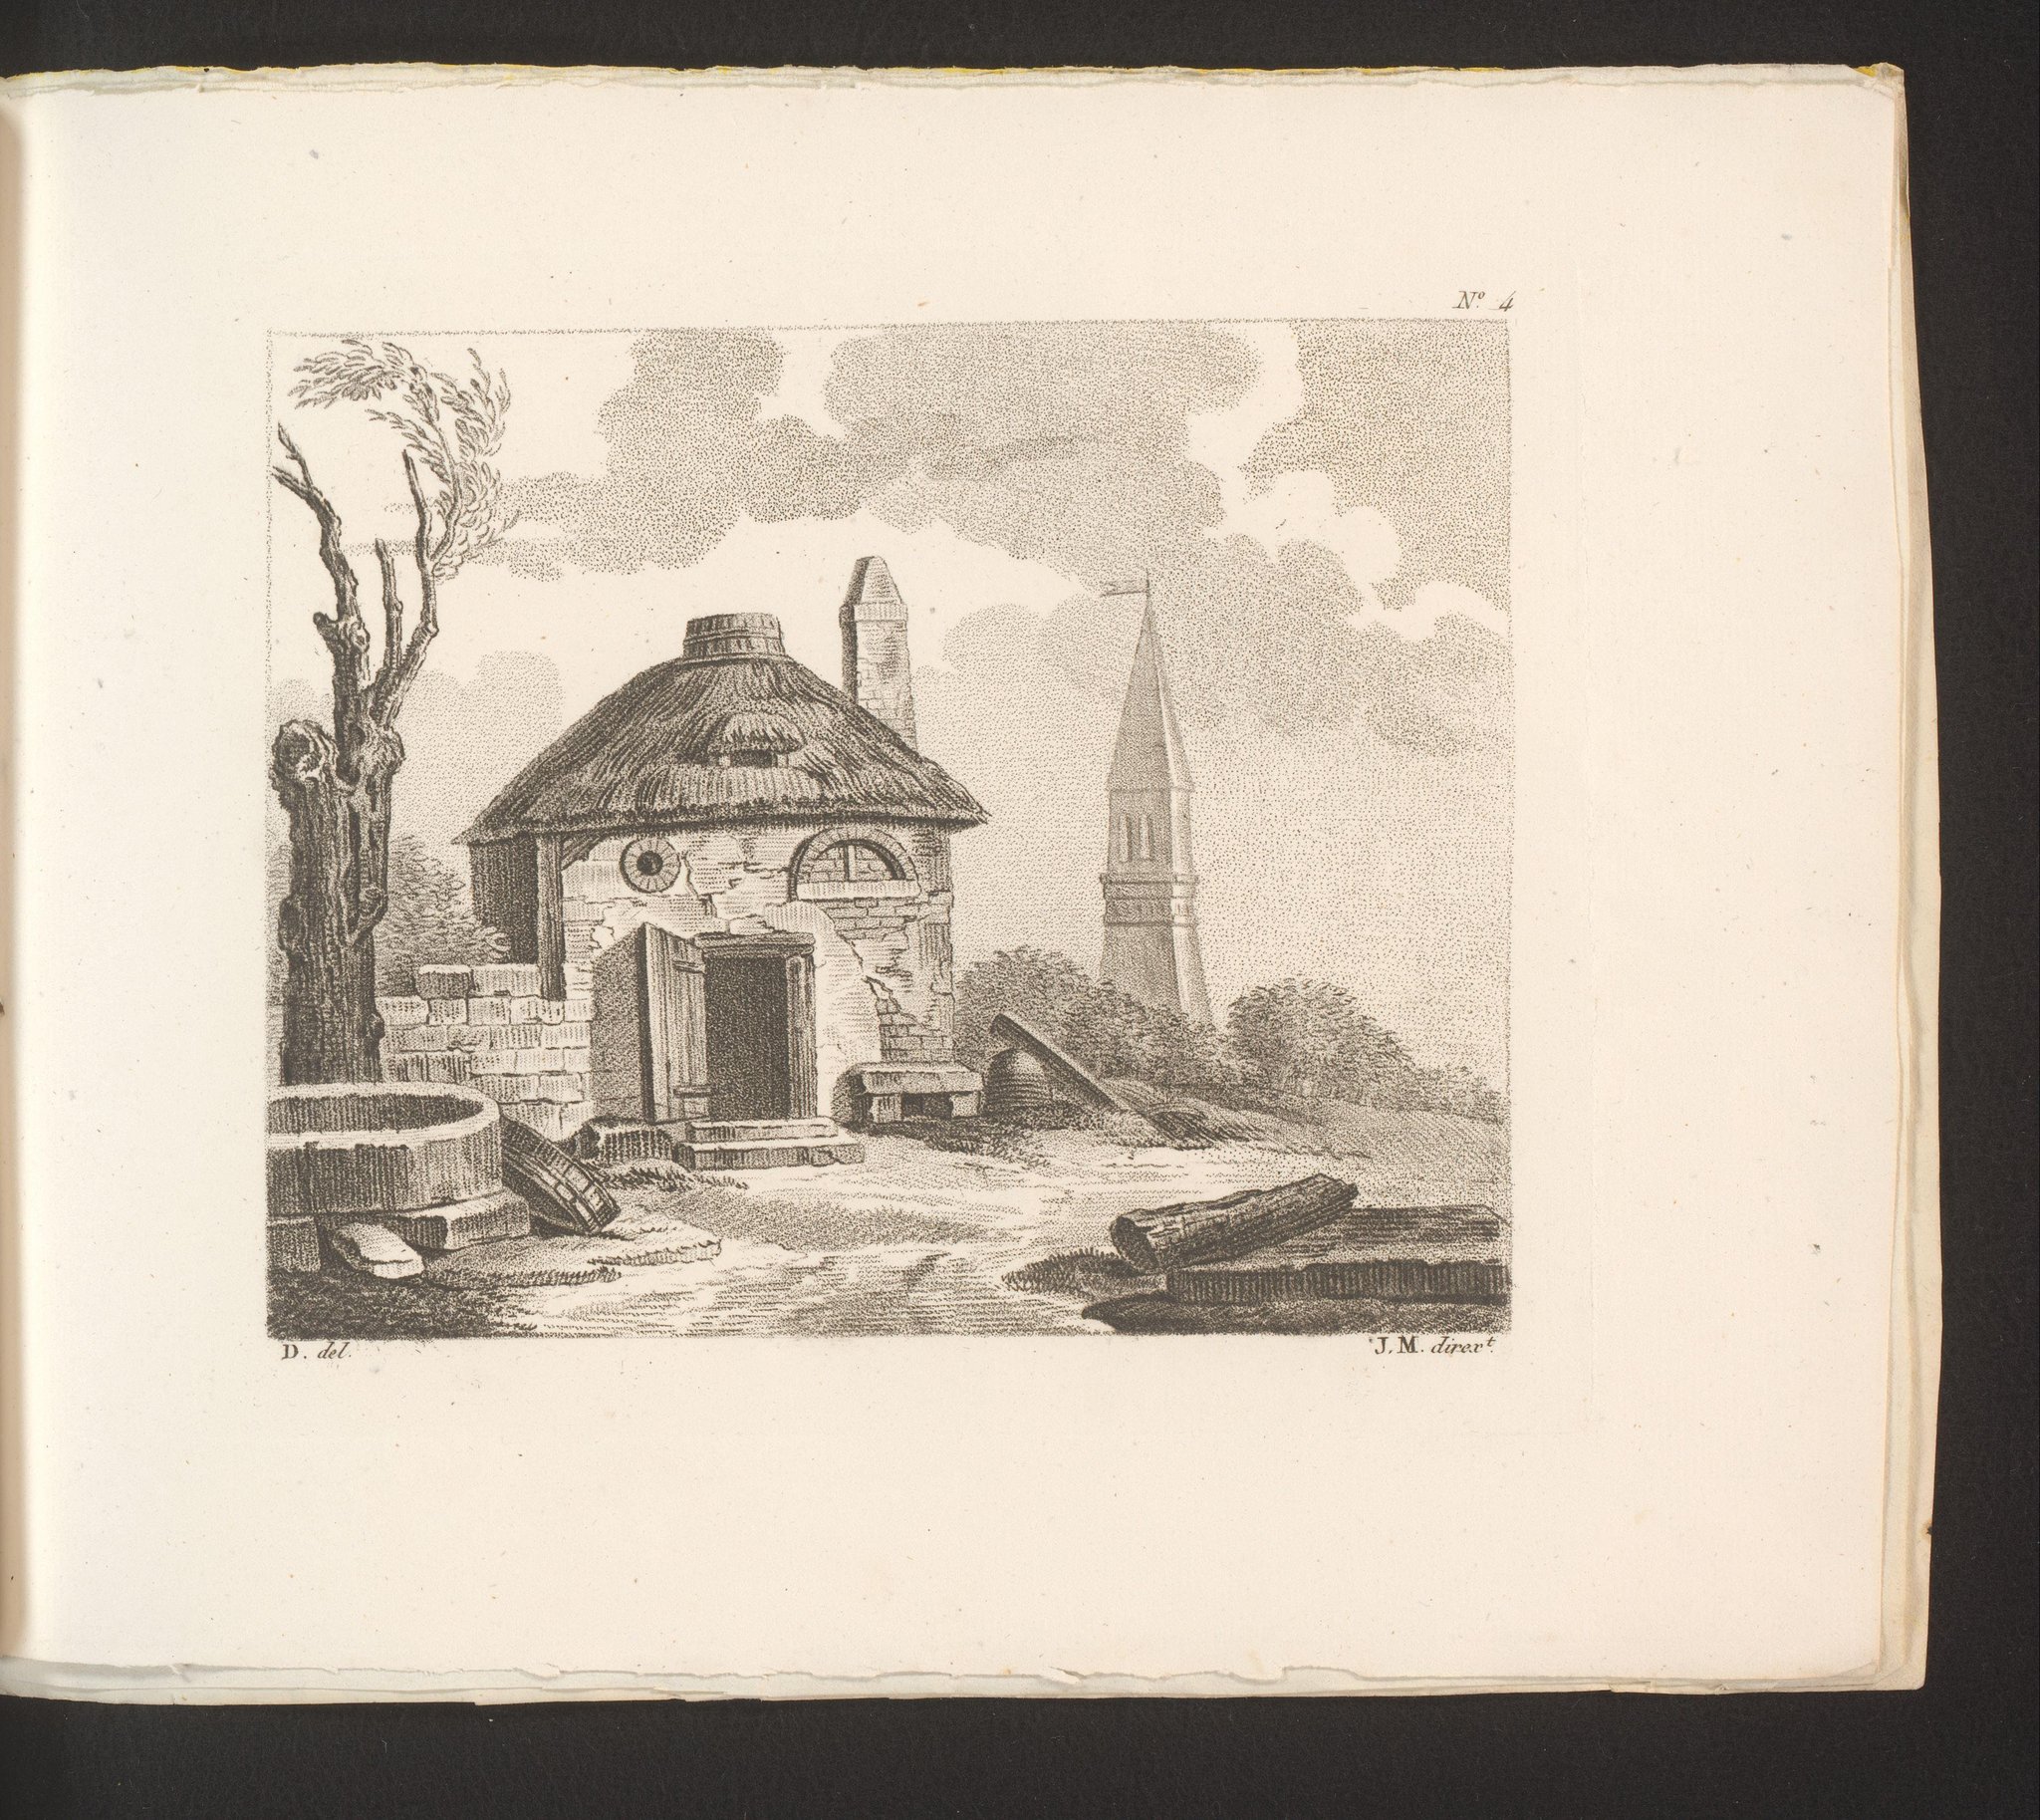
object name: album leaf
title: Schuur met openstaande deur en een toren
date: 1800-1825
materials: paper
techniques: printmaking, engraving, etching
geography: paris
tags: barn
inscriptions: collector's mark: Lugt 2760, collector's mark: Lugt 2228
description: Deze prent maakt deel uit van een album.